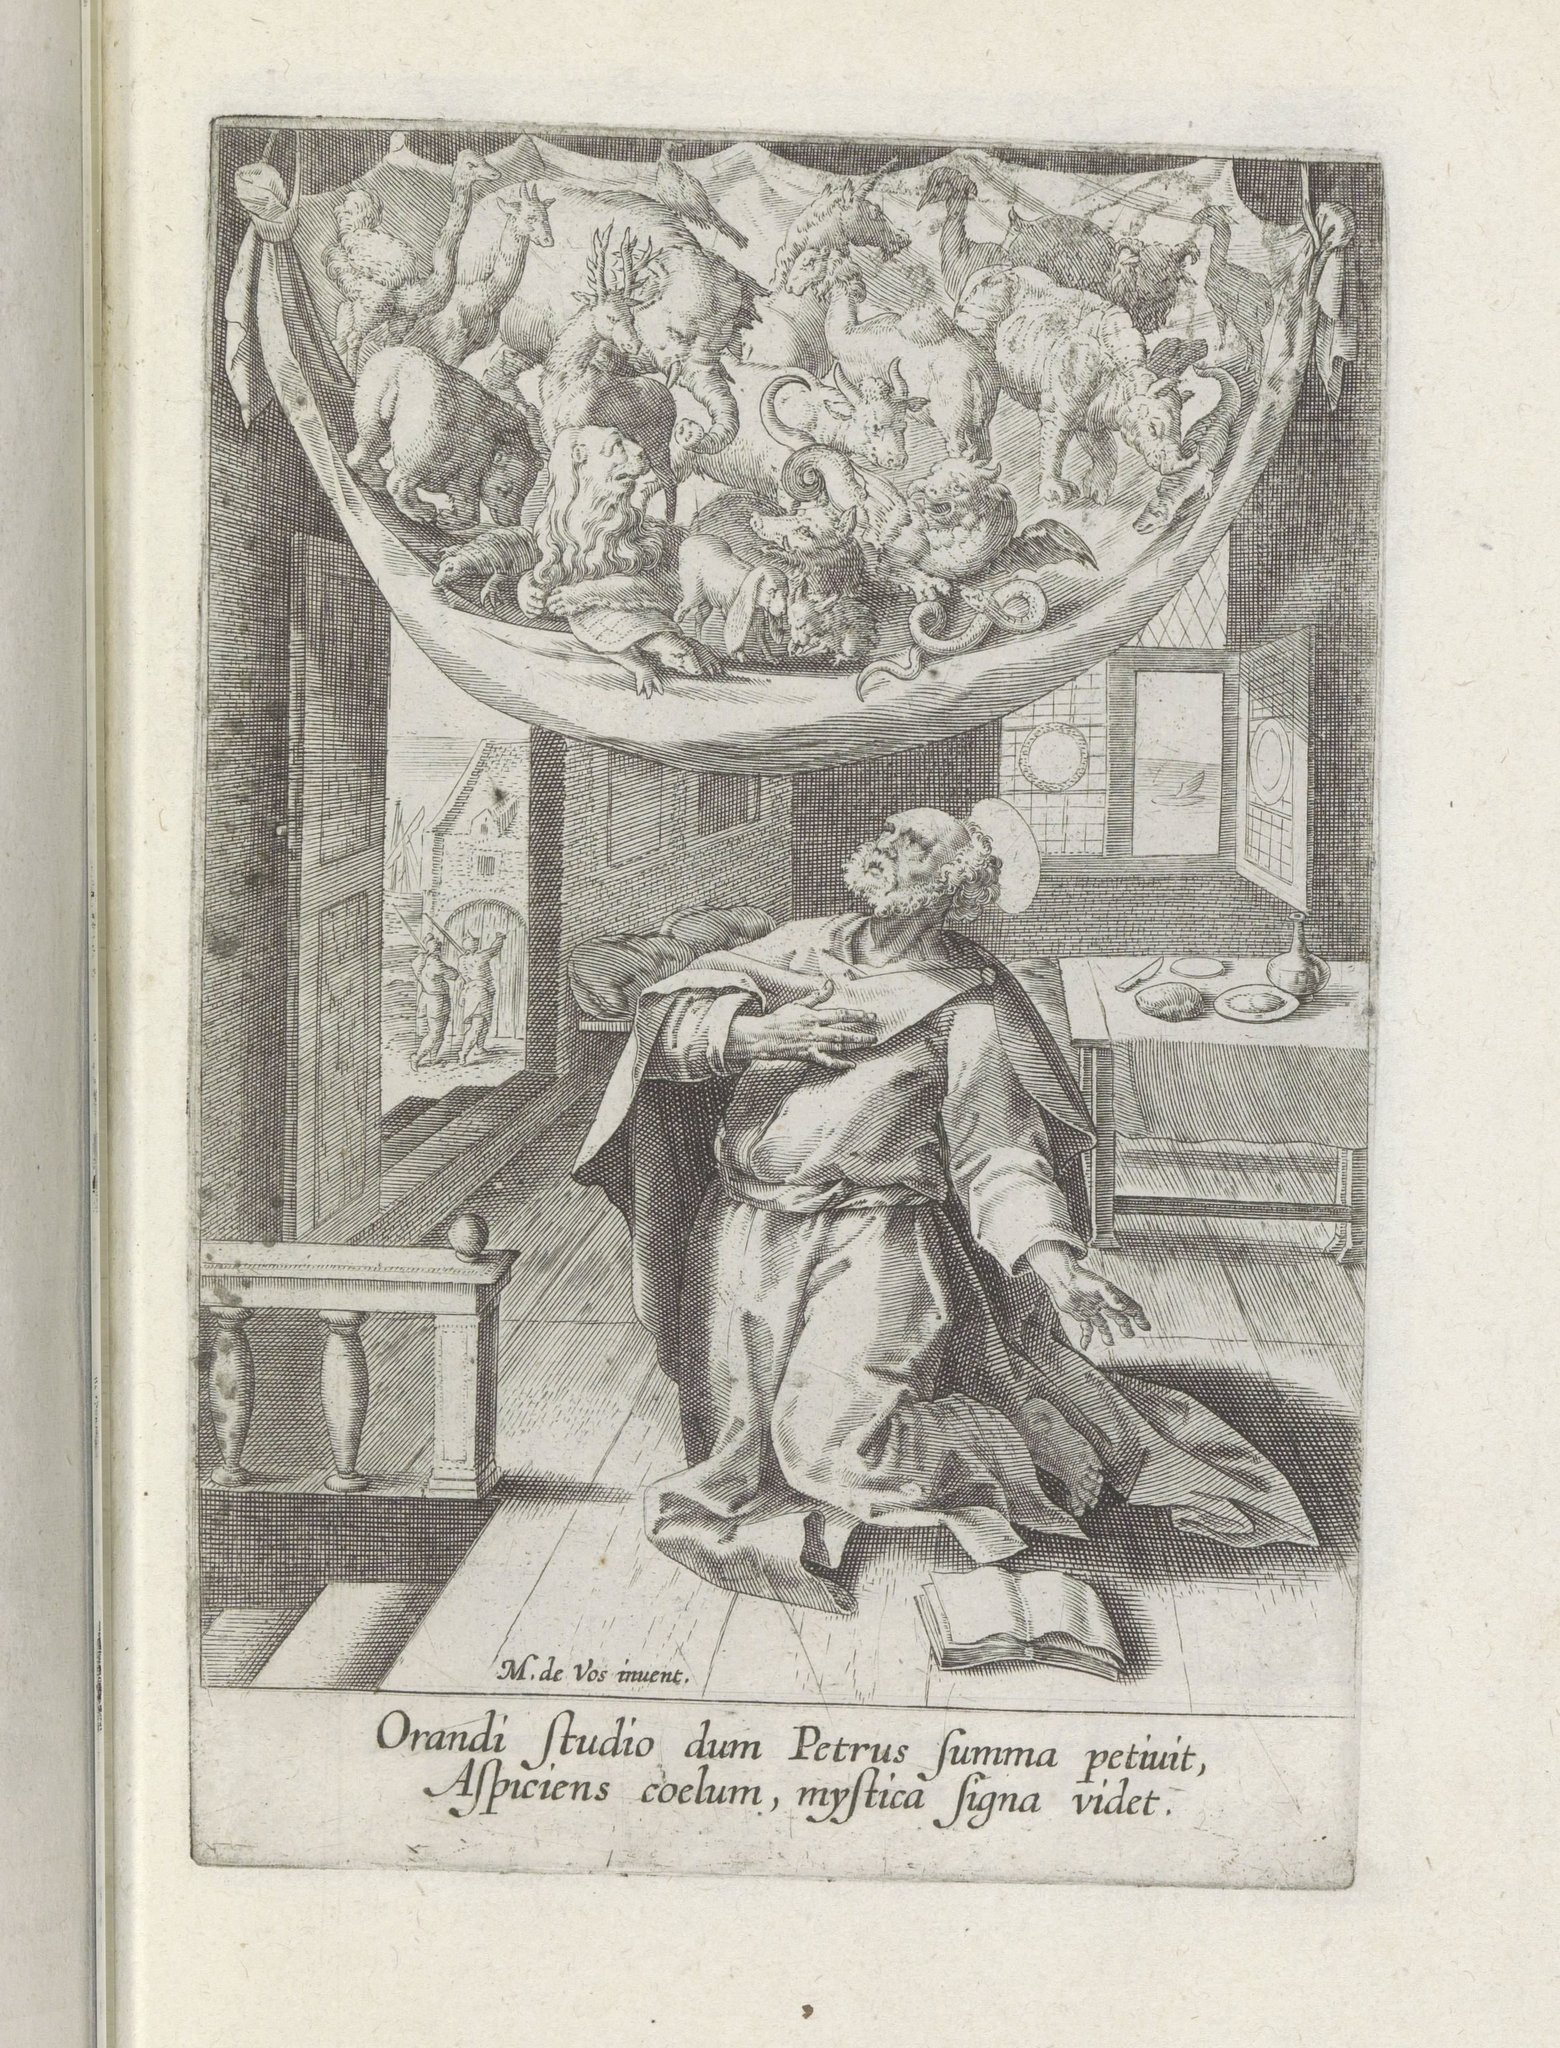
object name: print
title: Thesaurus novi Testamenti elegantissimis iconibus expressus continens historias atque miracula doni nostri Iesu Christi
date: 1585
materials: paper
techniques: engraving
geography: antwerp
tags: peter's vision of the unclean beasts on the roof of the house of simon the tanner: a sheet descends from heaven full of four-footed beasts, creeping things and fowl of the air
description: Deze serie draagt op een van de prenten het signatuur van de weduwe van uitgever Gerard de Jode. De eerste datering is gebaseerd op de datum van uitgave van het album. De tweede datering is gebaseerd op het sterfjaar van Gerard de Jode (1591) en het jaar waarin zijn zoon overleed (1600) en de platen werden verkocht. Het is mogelijk dat deze serie later aan het album is toegevoegd. Waarschijnlijker is het dat het gehele album tussen 1591 en 1600 is gebonden, omdat deze serie is meegebonden in het album.